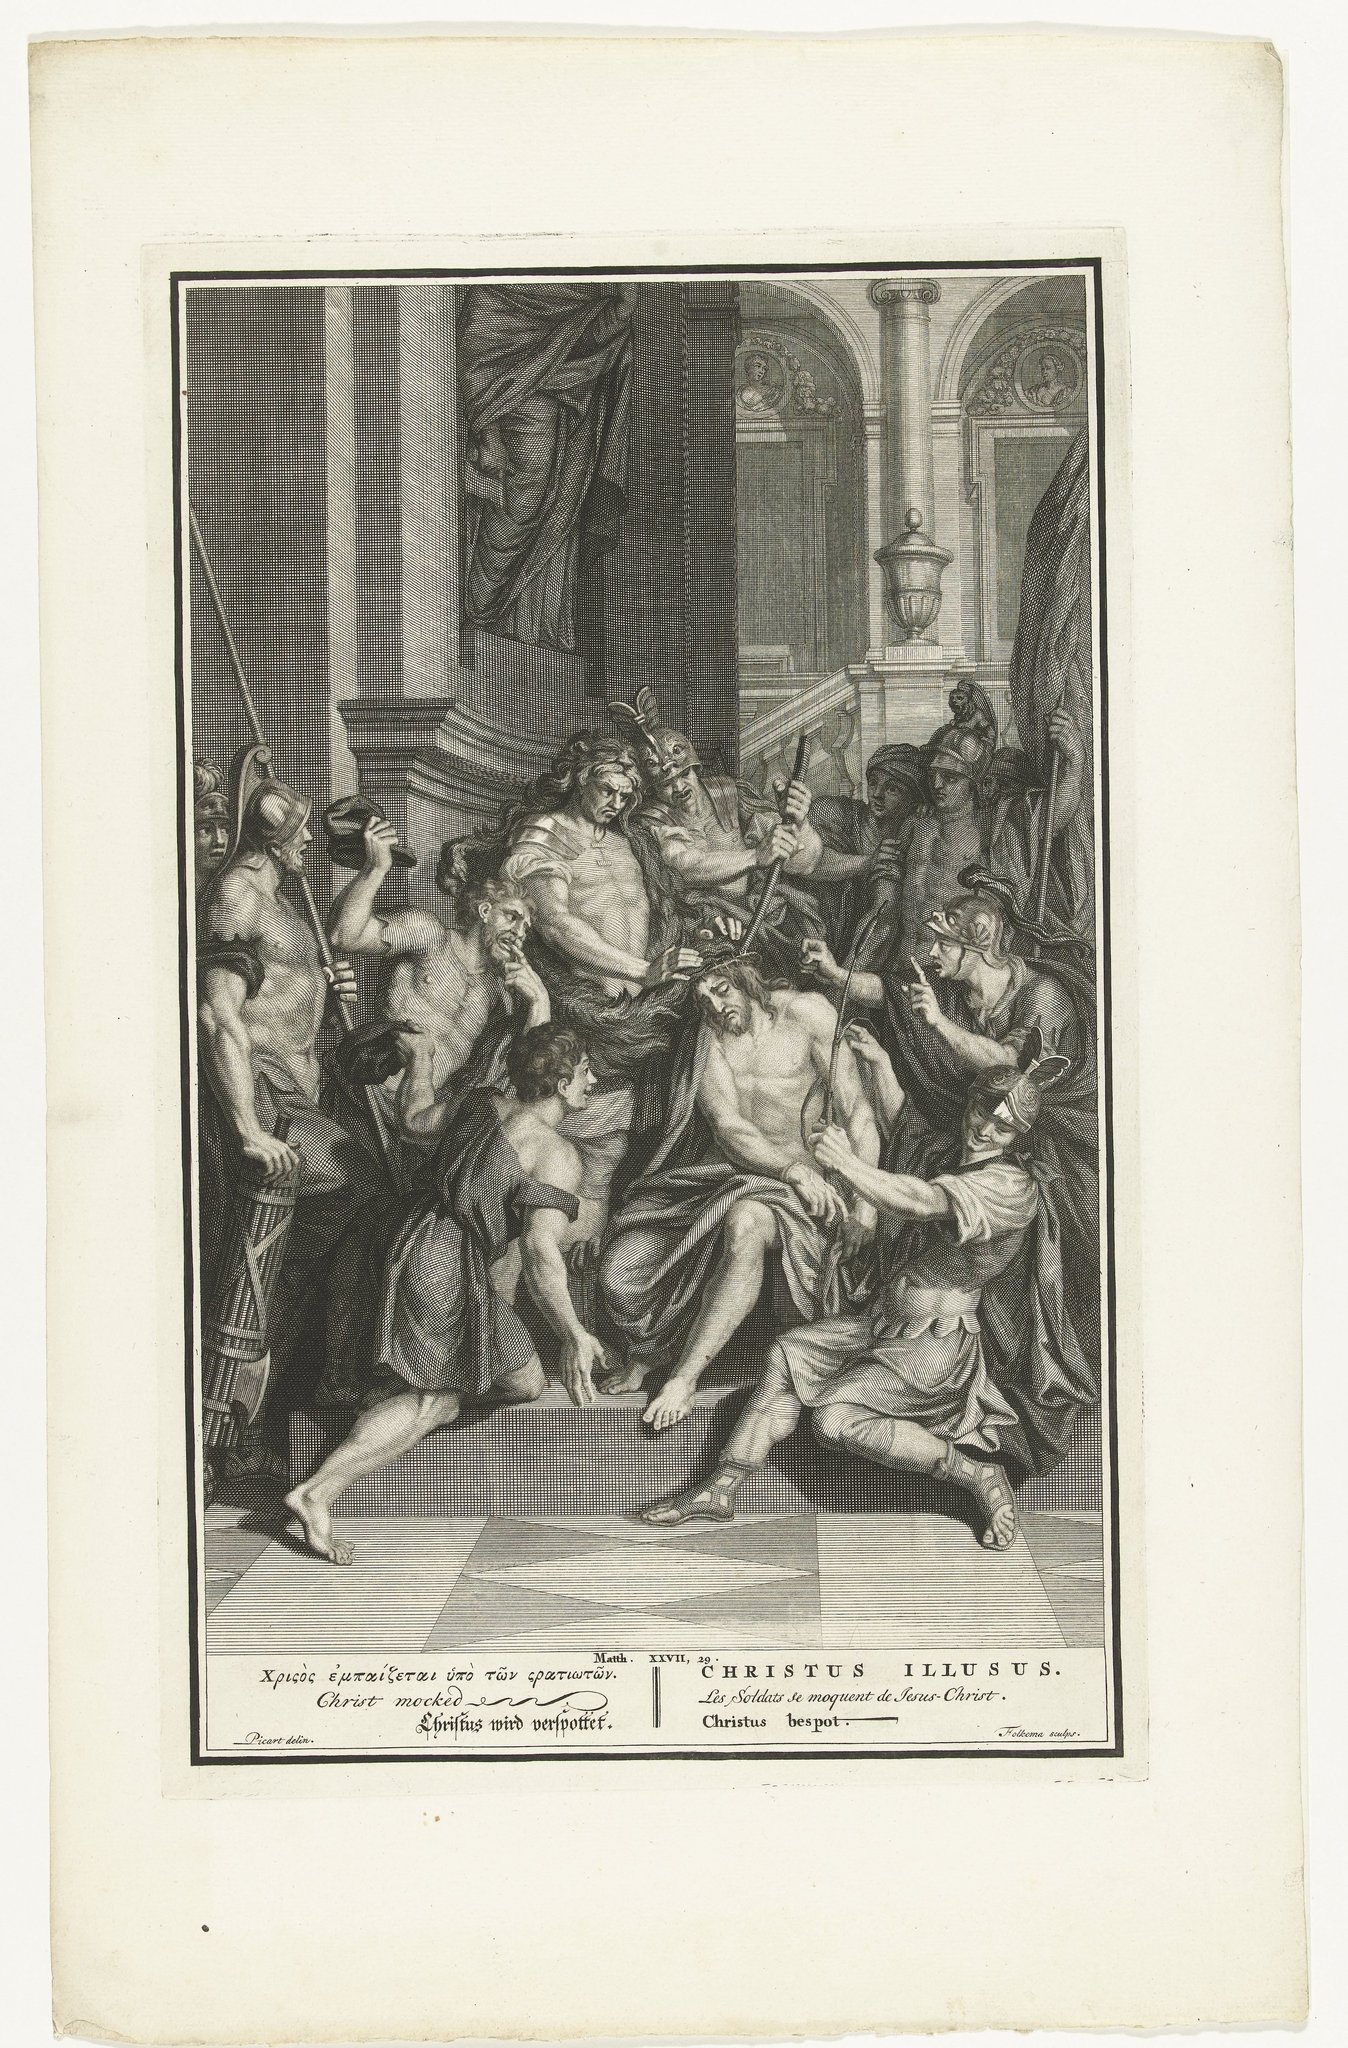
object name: print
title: Doornenkroning van Christus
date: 1702-1767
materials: paper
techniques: engraving, etching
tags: the crowning with thorns: soldiers with sticks place a thorny crown on christ's head and give him a reed (matthew 27:27-31; mark 15:16-20; john 19:2-3)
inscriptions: inscription: ‘Utrechts Fundatie huijs’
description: Christus wordt door soldaten bespot. Hij krijgt een doornenkroon op zijn hoofd en een grasspriet als scepter. Bijbelse voorstelling uit Mat. 27:29 met in de marge de titel van de voorstelling in zes talen.